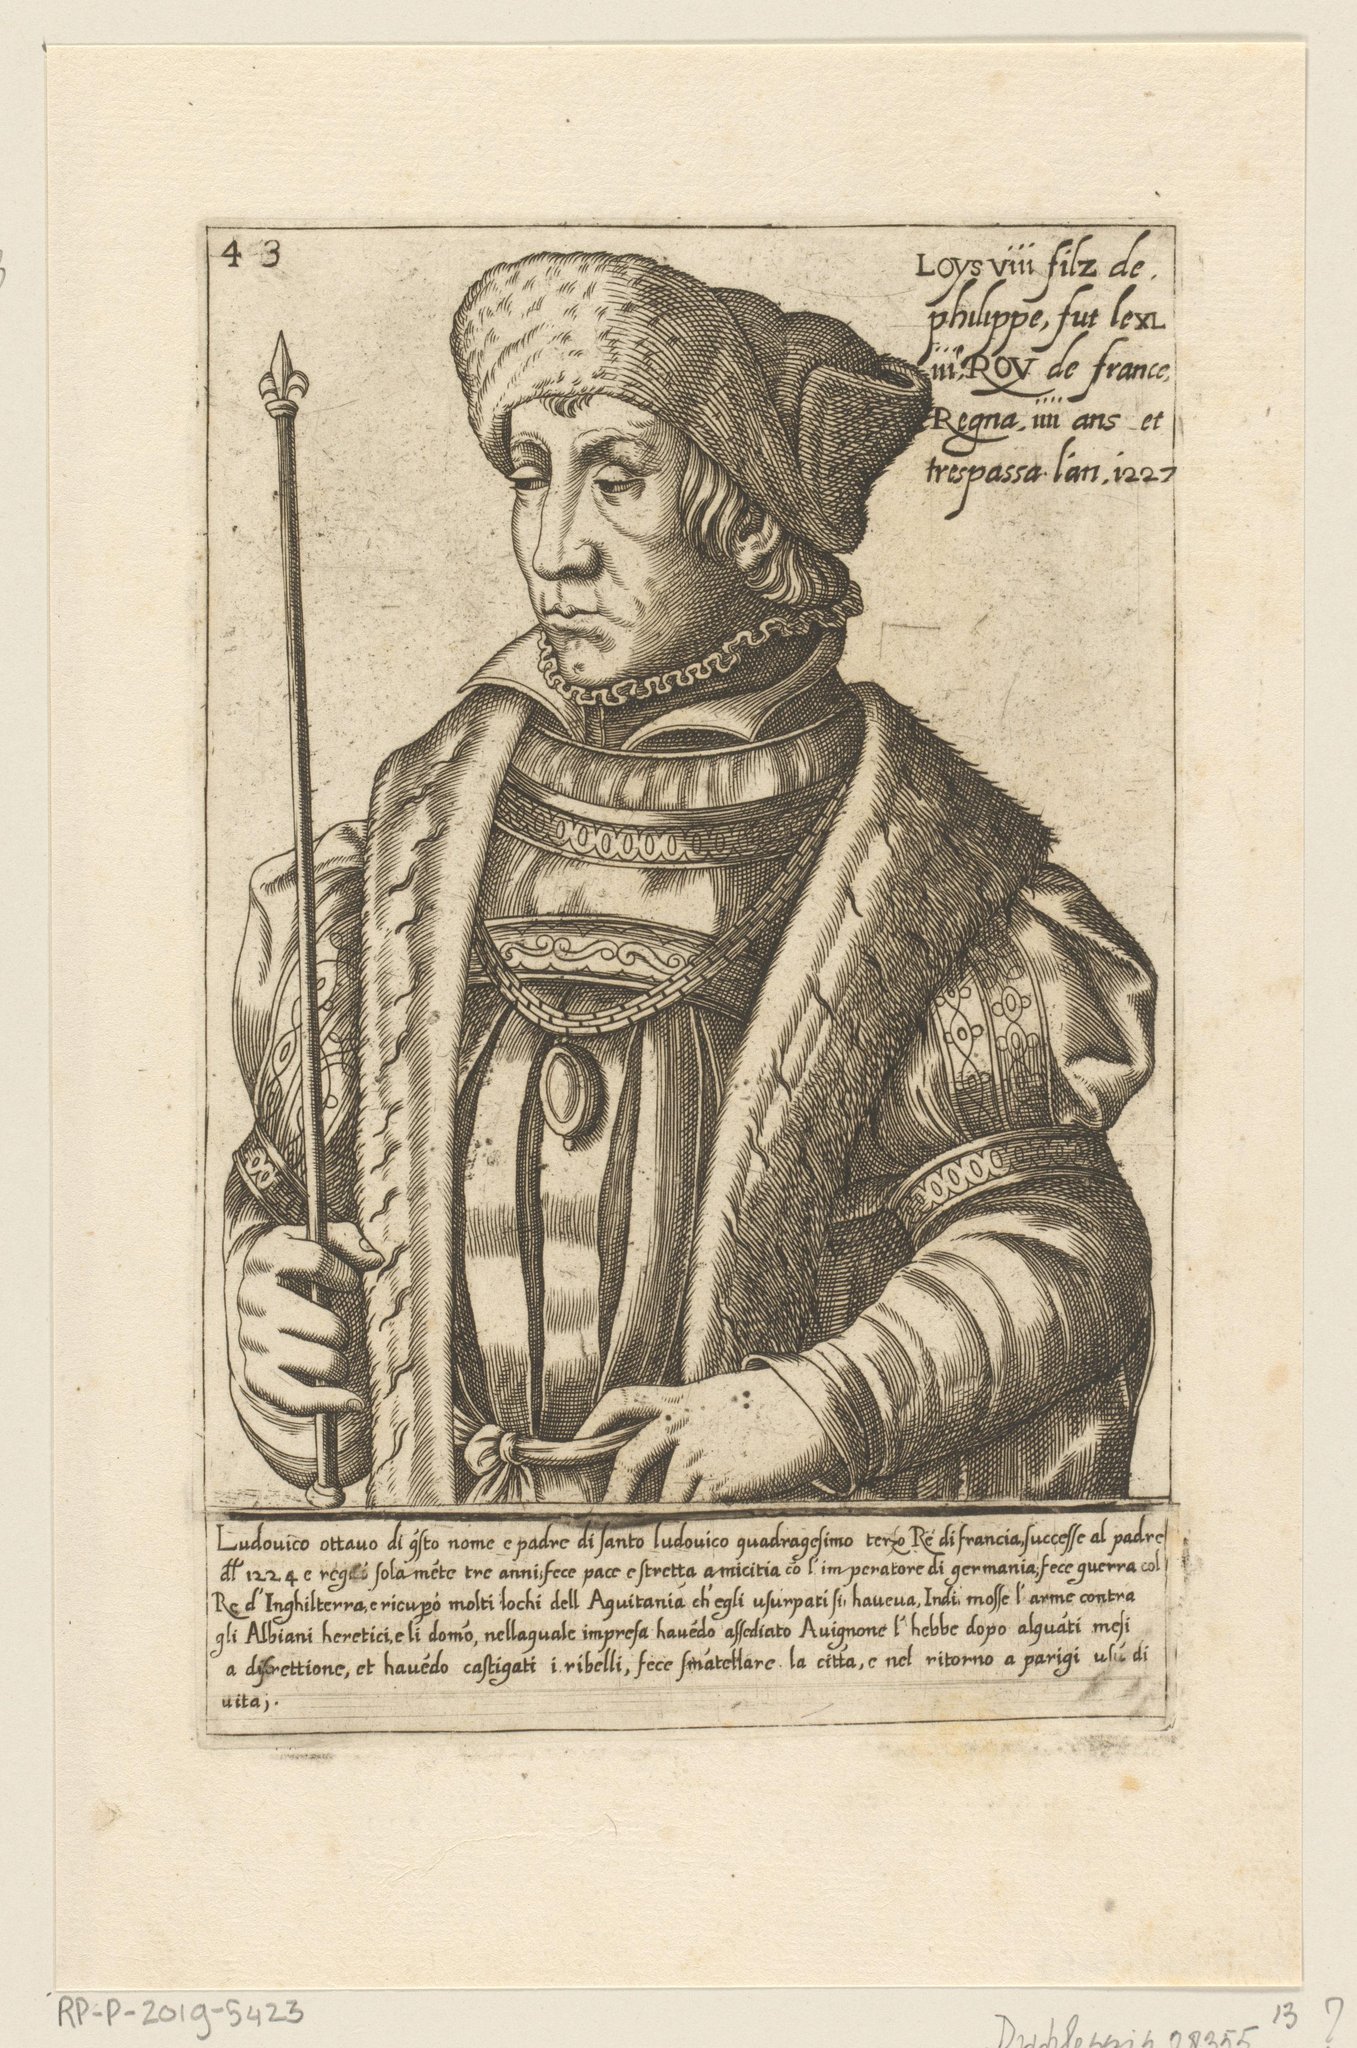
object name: book illustration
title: Portret van Lodewijk VIII, koning van Frankrijk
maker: Anonymous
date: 1588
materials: paper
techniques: engraving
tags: sceptre, staff (symbol of sovereignty), historical persons, head-gear: hat, king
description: Prent voor het eerst gebruikt in: Cronica Breve de i fatti illustri de're di Francia, con le loro effigie dal naturale cominciando da Faramondo (...). Venetië: Bernardo Giunti, 1588. Prent in ieder geval ook gebruikt in de editie van 1590 en mogelijk ook in een Franse uitgave van 1597.